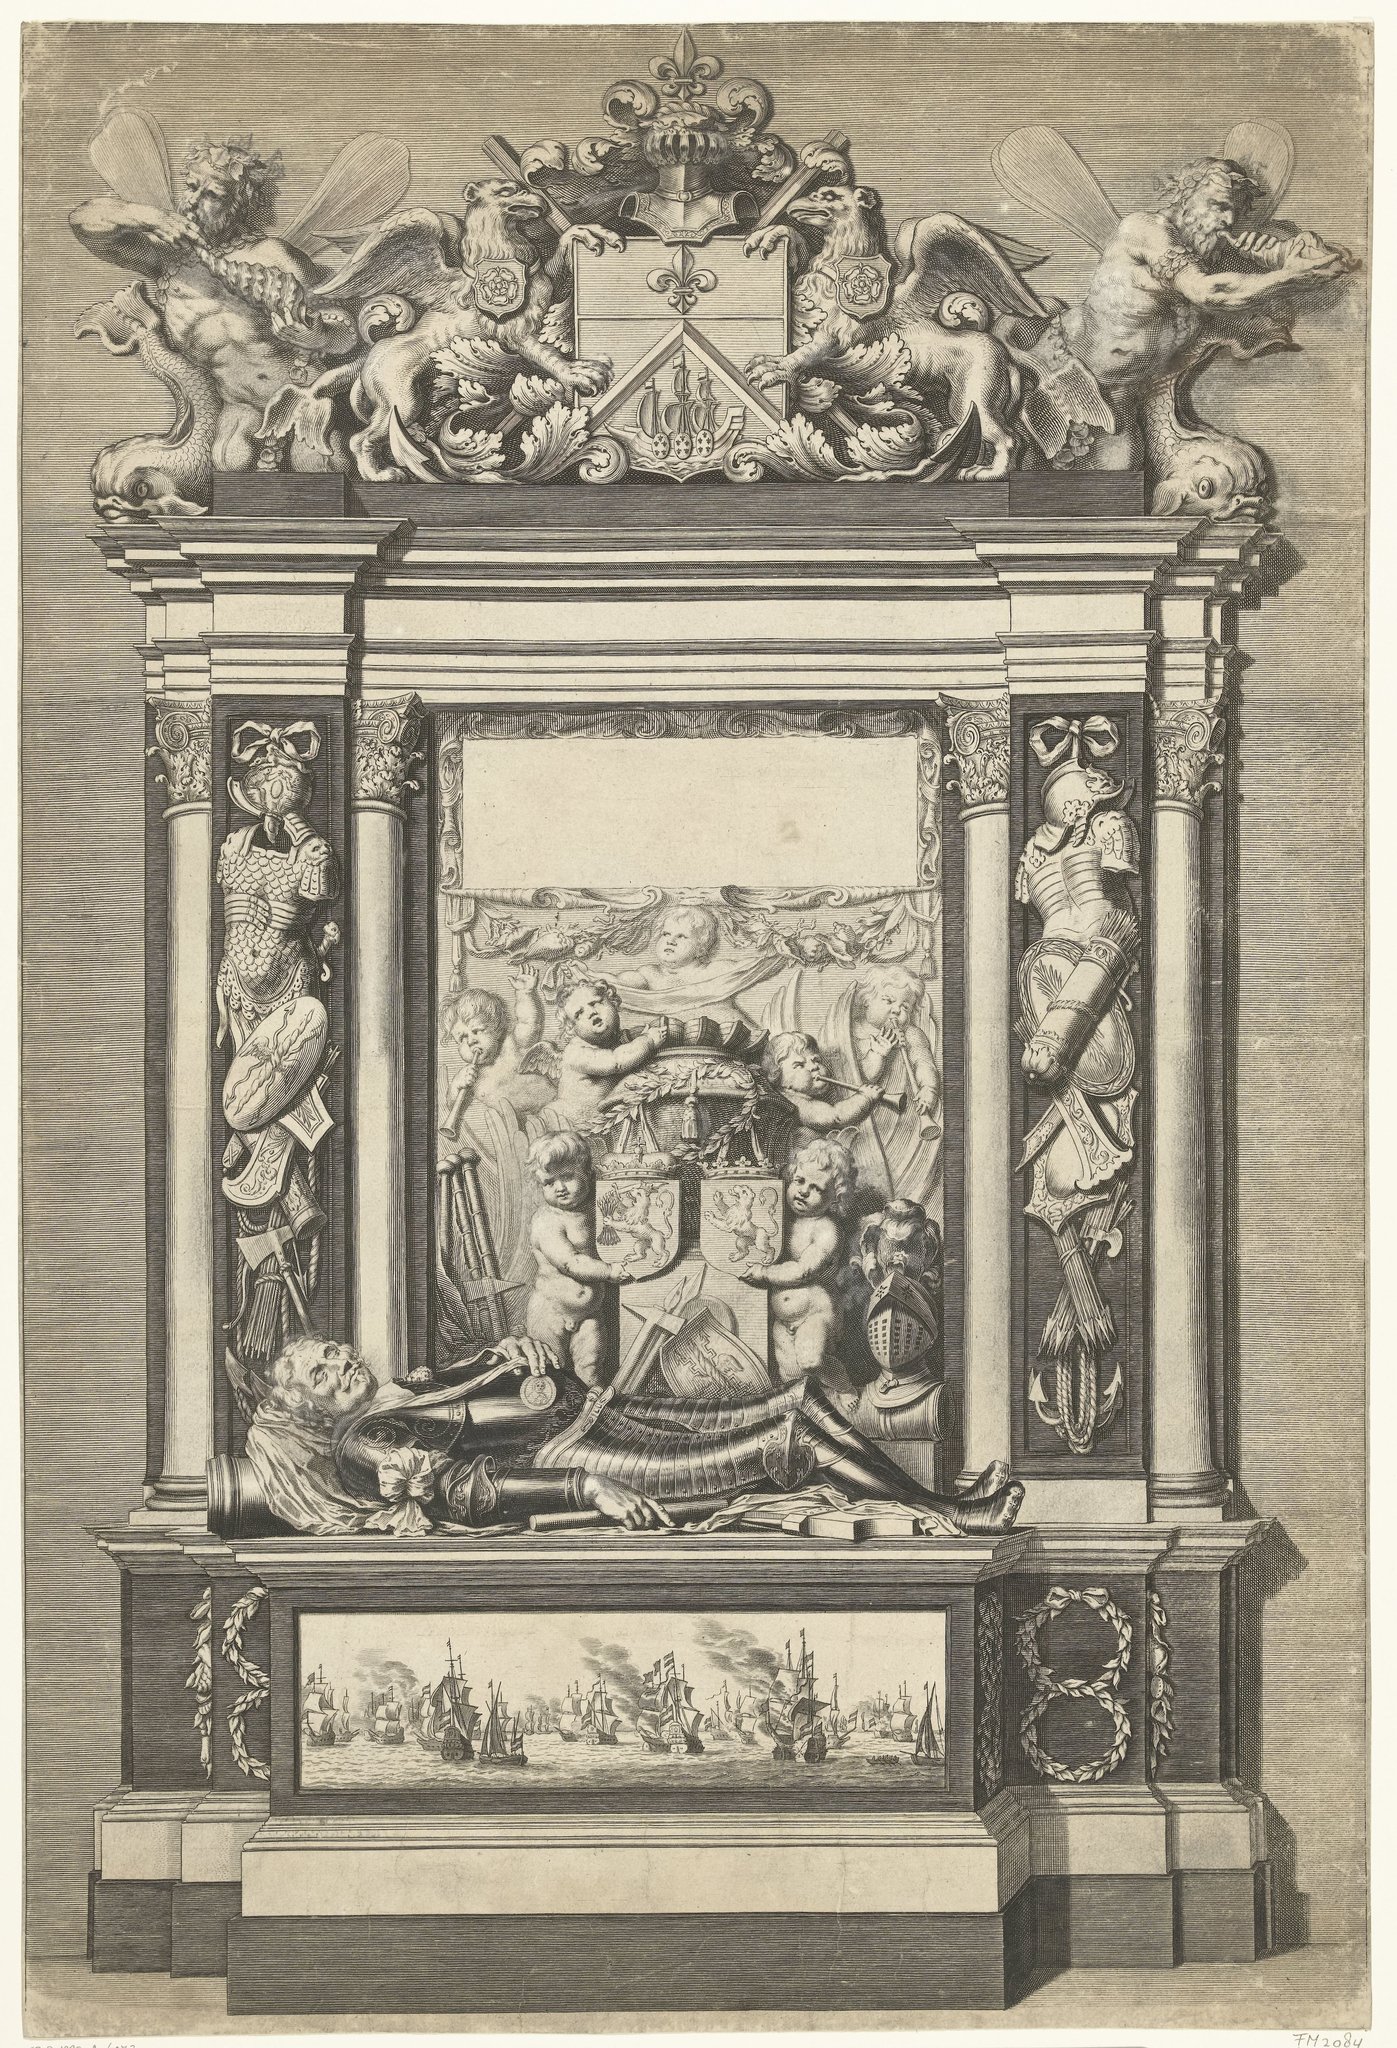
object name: print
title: Graftombe van admiraal Maarten Harpertsz. Tromp in Oude Kerk te Delft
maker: cornelis van dalen (ii)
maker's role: draughtsman, print maker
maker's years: 1638-1664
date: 1656-1664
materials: chalk, ink, paper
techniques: engraving, pen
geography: amsterdam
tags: grave-building, monumental tomb, battle of scheveningen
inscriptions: collector's mark: Lugt 2228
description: Graftombe van admiraal Maarten Harpertsz. Tromp in Oude Kerk te Delft. Beeld van de gesneuvelde admiraal in harnas liggend op tombe met zeeslag bij Terheide op fries. Tegen de wand marmeren reliëf met putti met wapenschilden en wapenrusting geflankeerd door zuilen en militaria. Bovenop lijst bekroond met wapendschild vastgehouden door griffioenen en geflankeerd door tritons of meermannen.